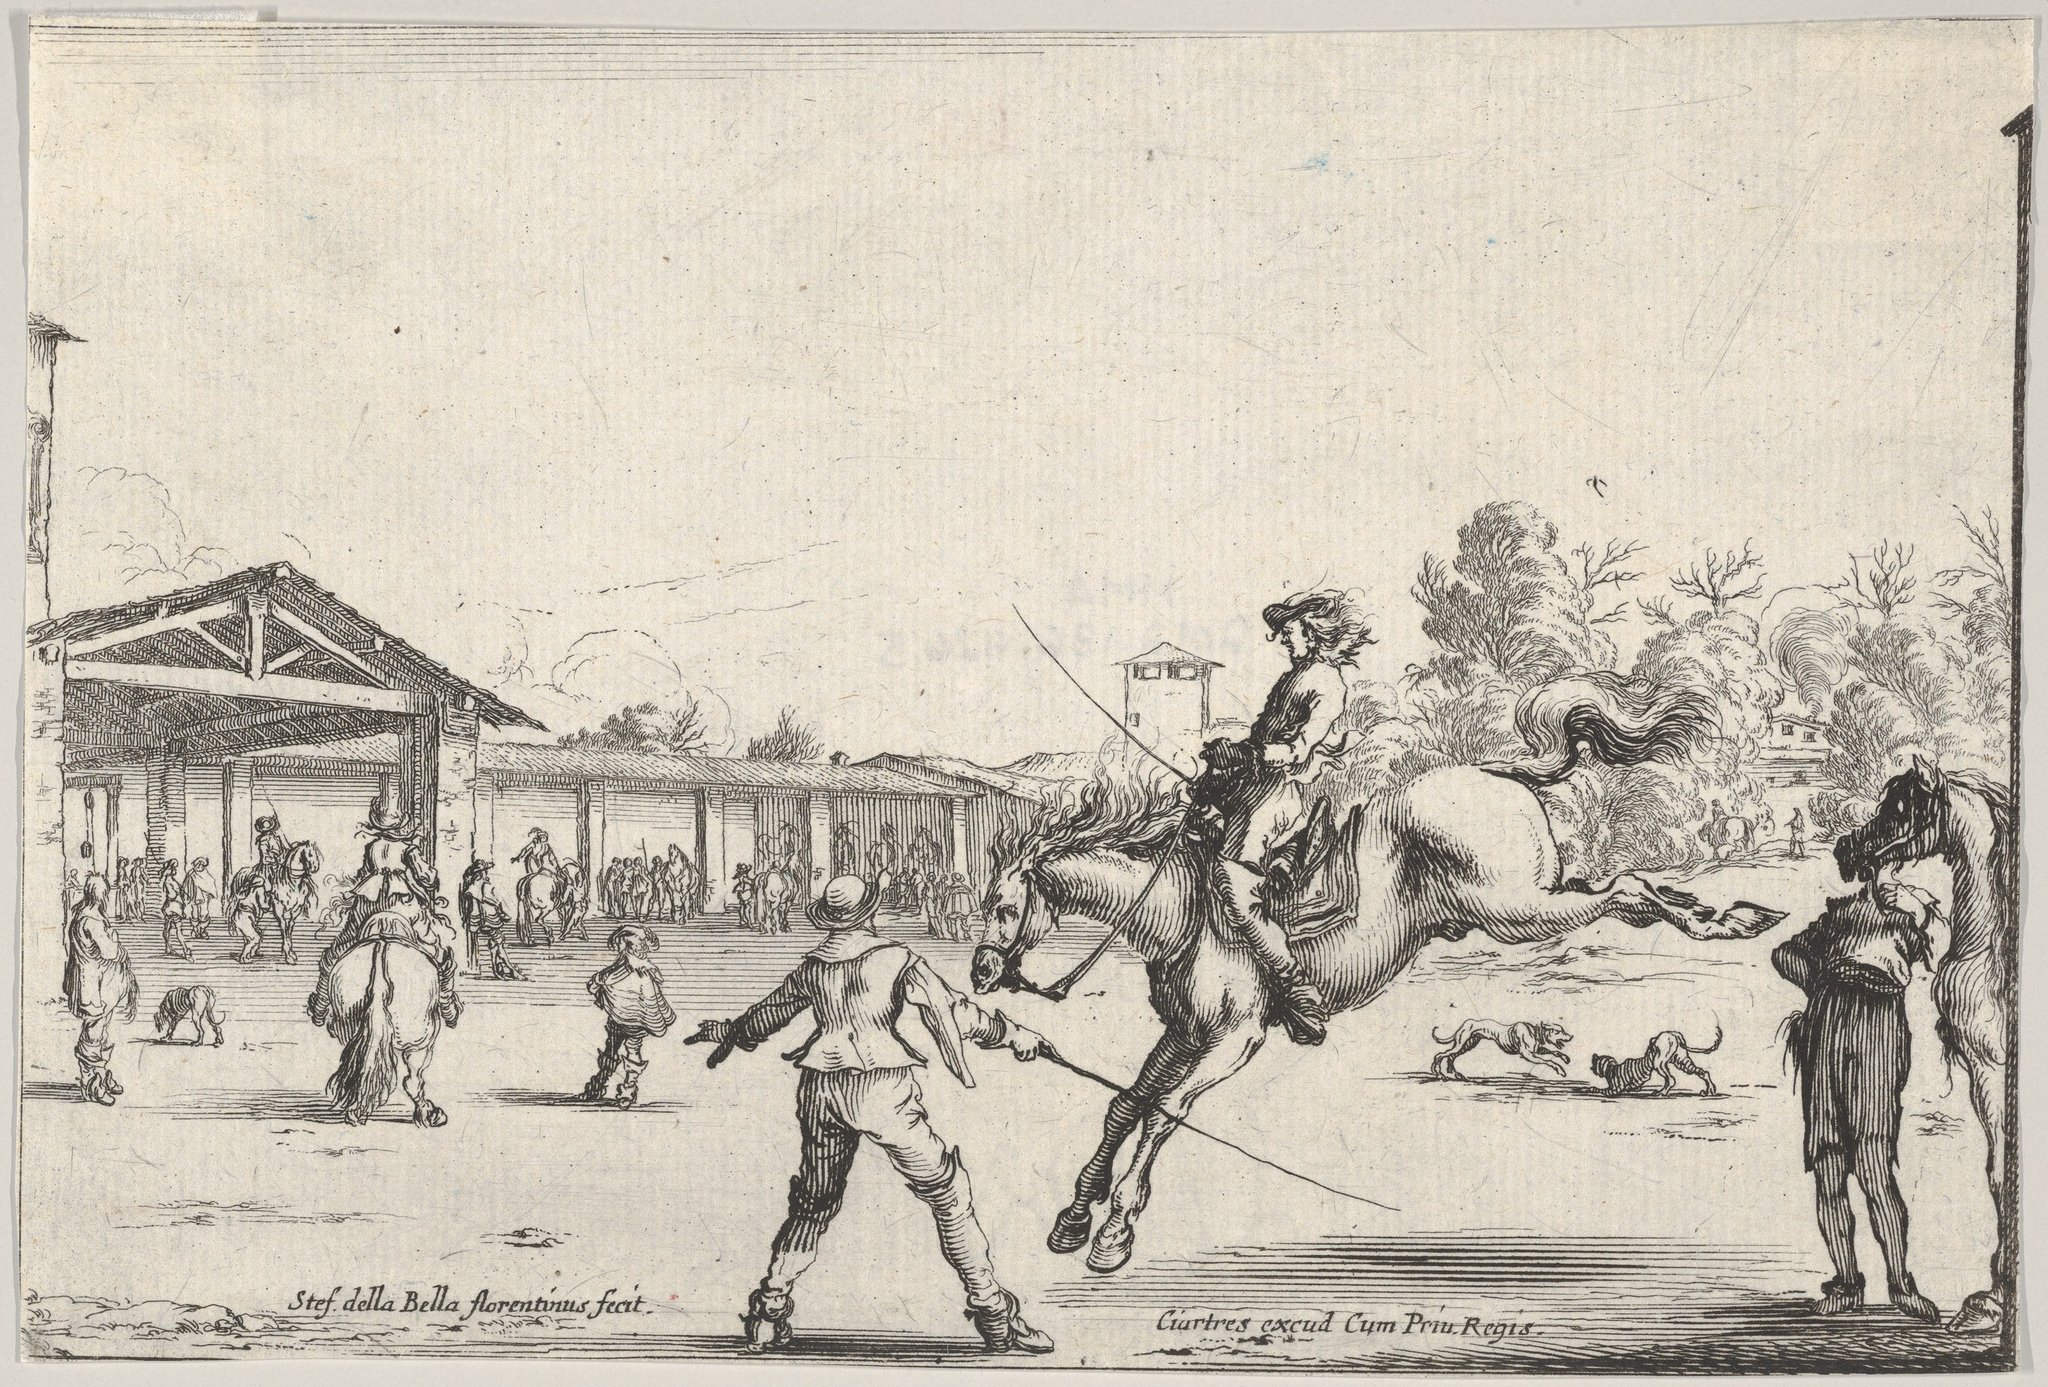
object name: print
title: A riding school, a horseman with sword jumping directed by another man with a sword in center, a man standing next to his horse to right, various horsemen, the school, and two dogs in the background, from "Varie Figure"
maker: stefano della bella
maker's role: artist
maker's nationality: italian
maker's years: 1610-1664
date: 1645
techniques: etching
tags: schools,men,dogs,horses,students,teachers